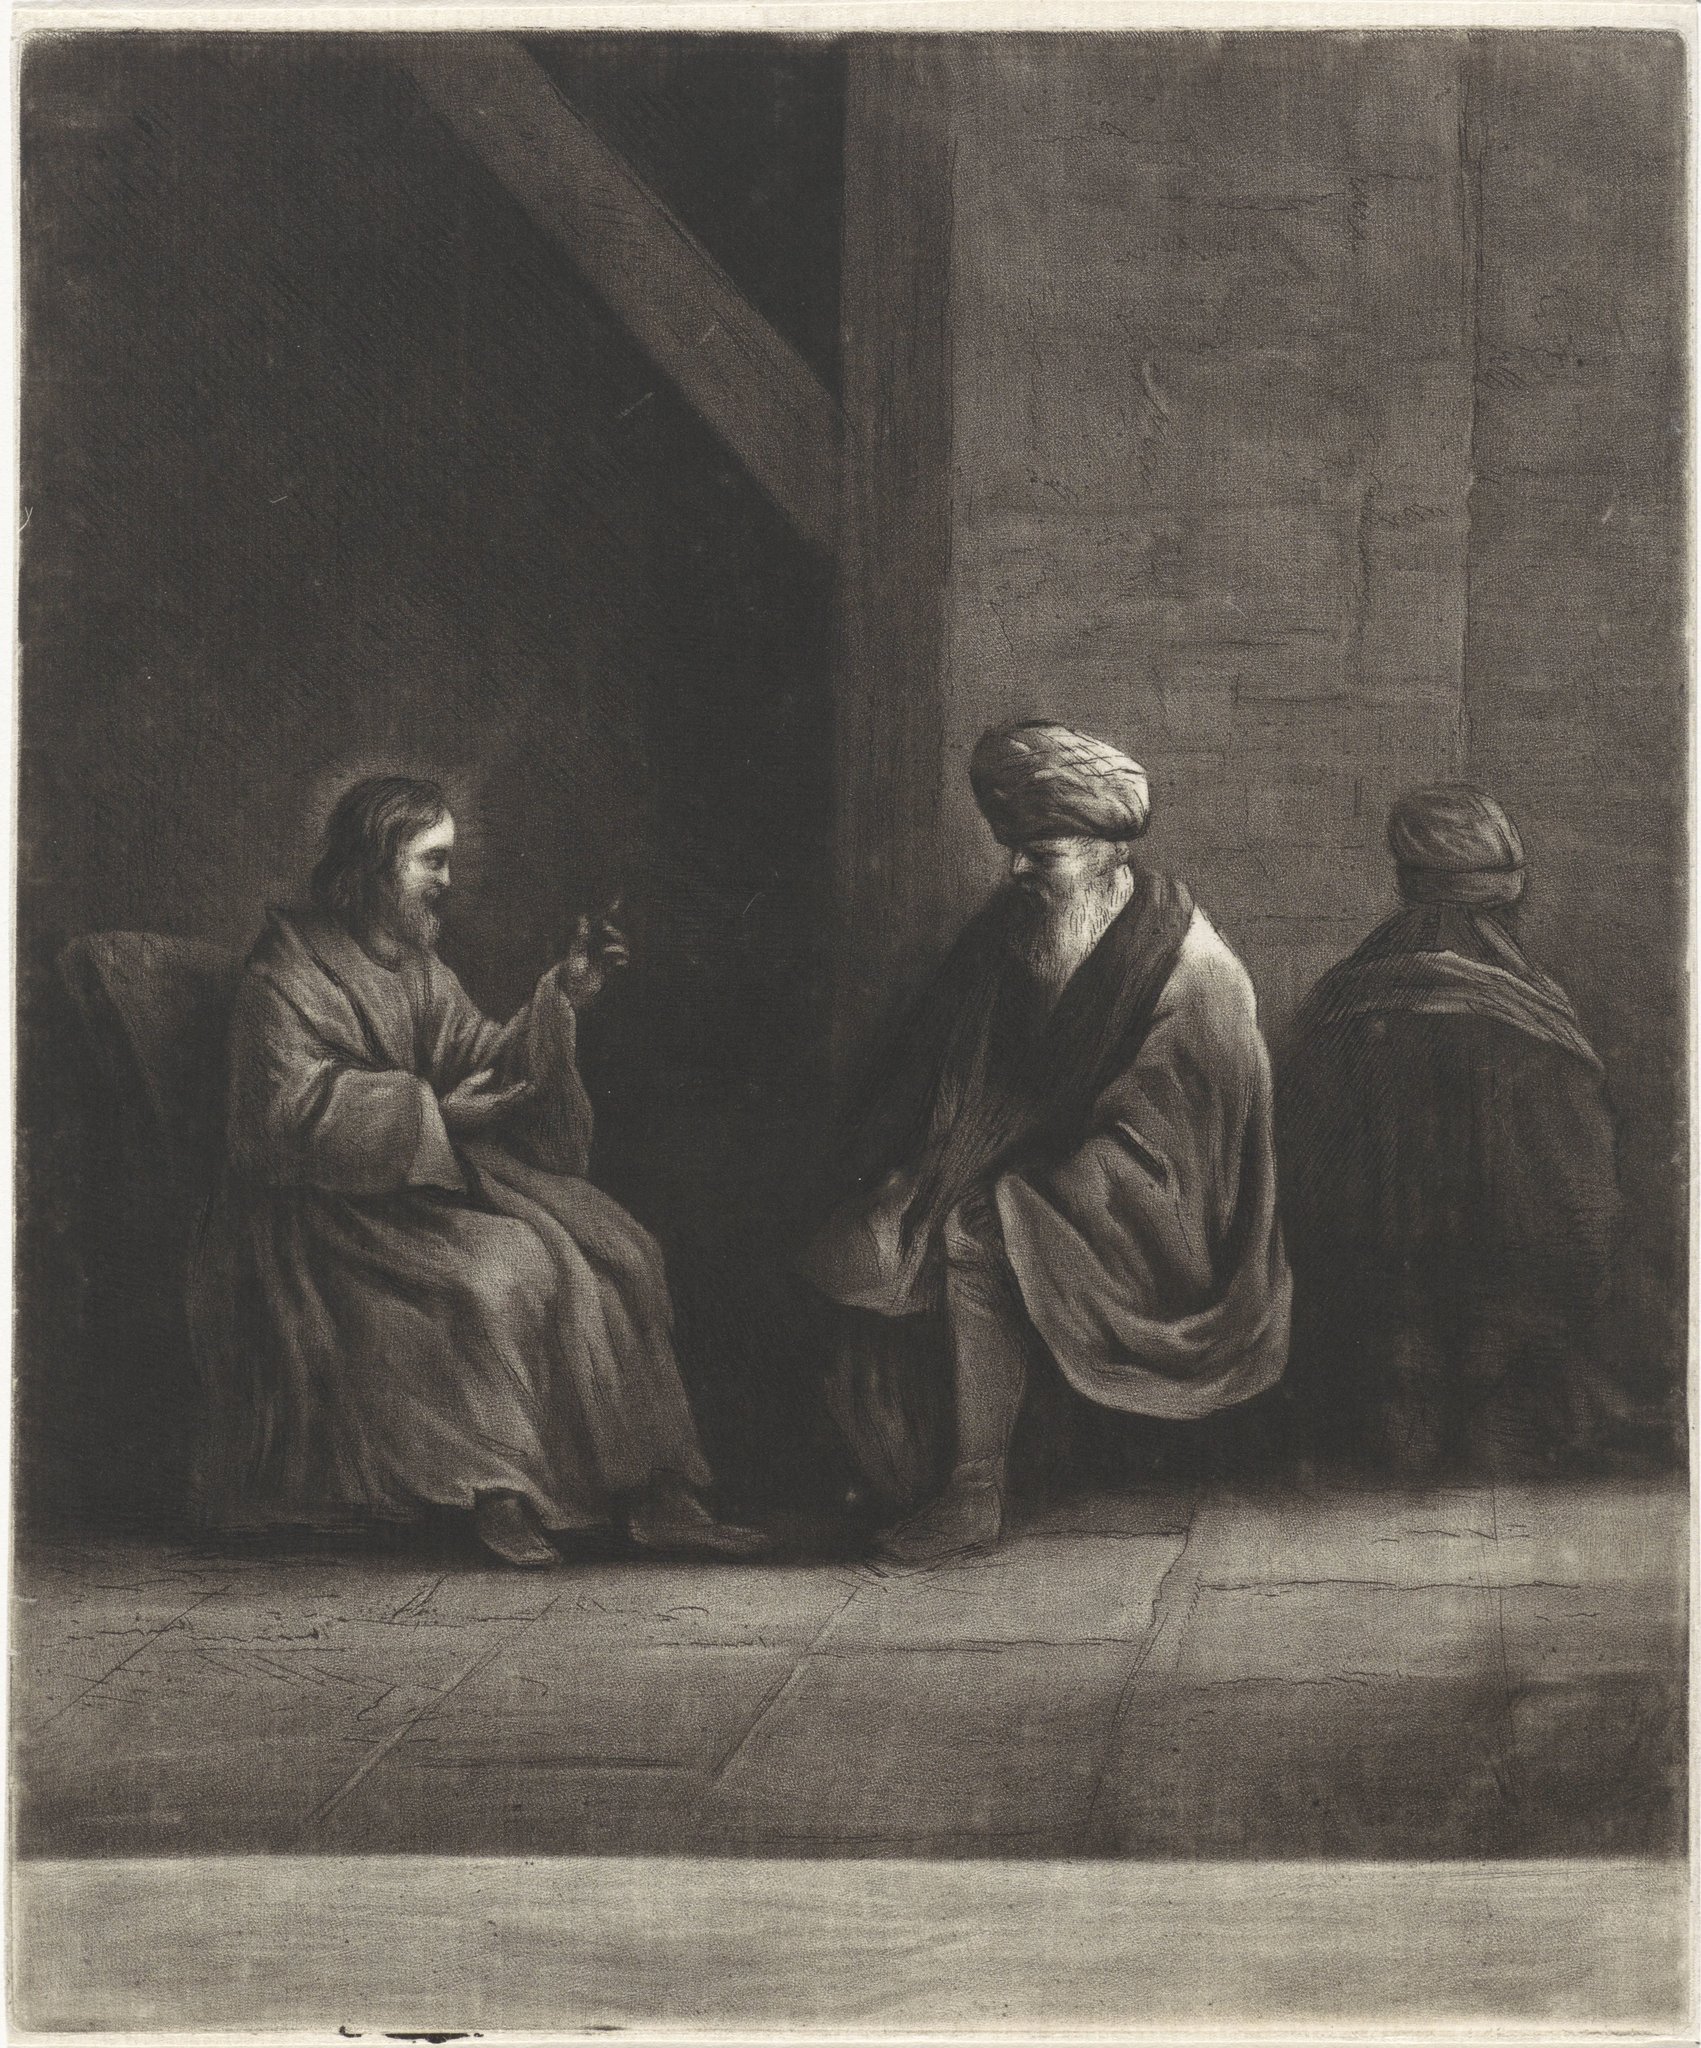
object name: print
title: Christus en Nicodemus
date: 1739-1792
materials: paper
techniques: etching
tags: christ talking with nicodemus at night (john 3:1-21)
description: Christus in gesprek met Nicodemus, bij nacht.